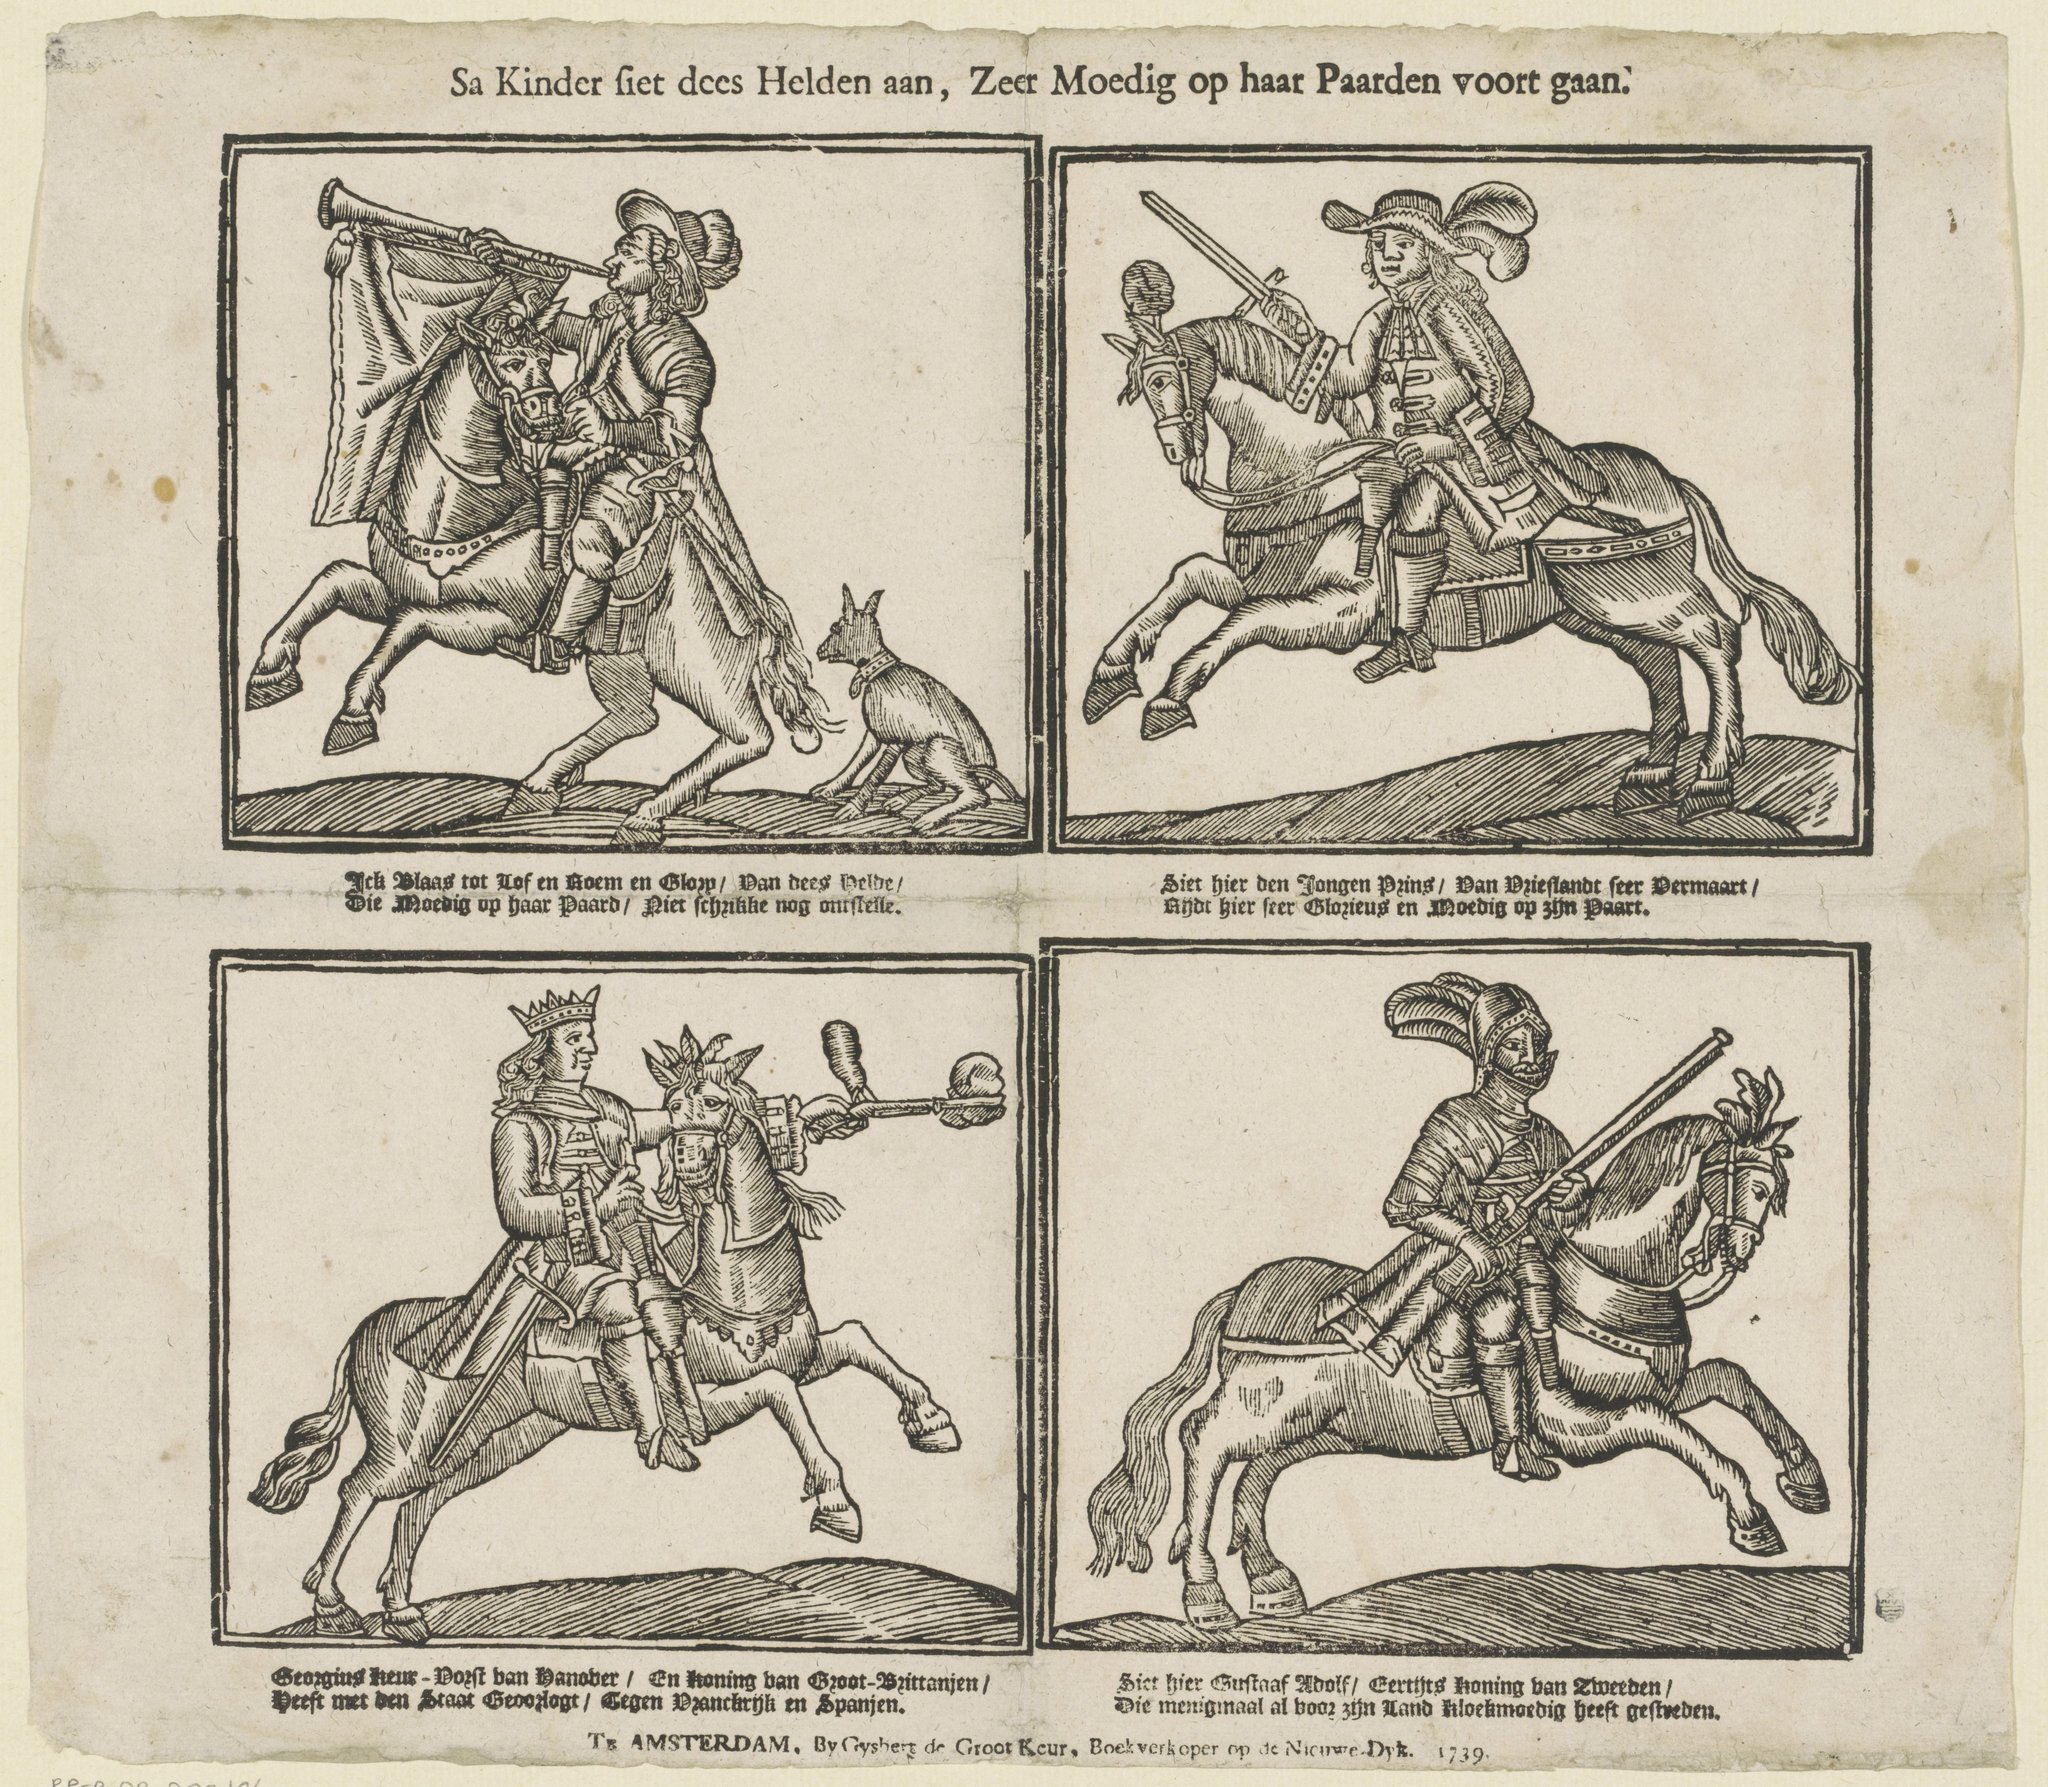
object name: print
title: Sa kinder siet dees helden aan, Zeer moedig op haar paarden voort gaan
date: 1739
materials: paper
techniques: letterpress printing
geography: amsterdam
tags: weapons, warfare; military affairs (+ cavalry, horsemen), the soldier; the soldier's life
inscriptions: collector's mark: Lugt 2760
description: Blad met 4 voorstellingen van militairen te paard. Onder elke afbeelding een tweeregelig vers.